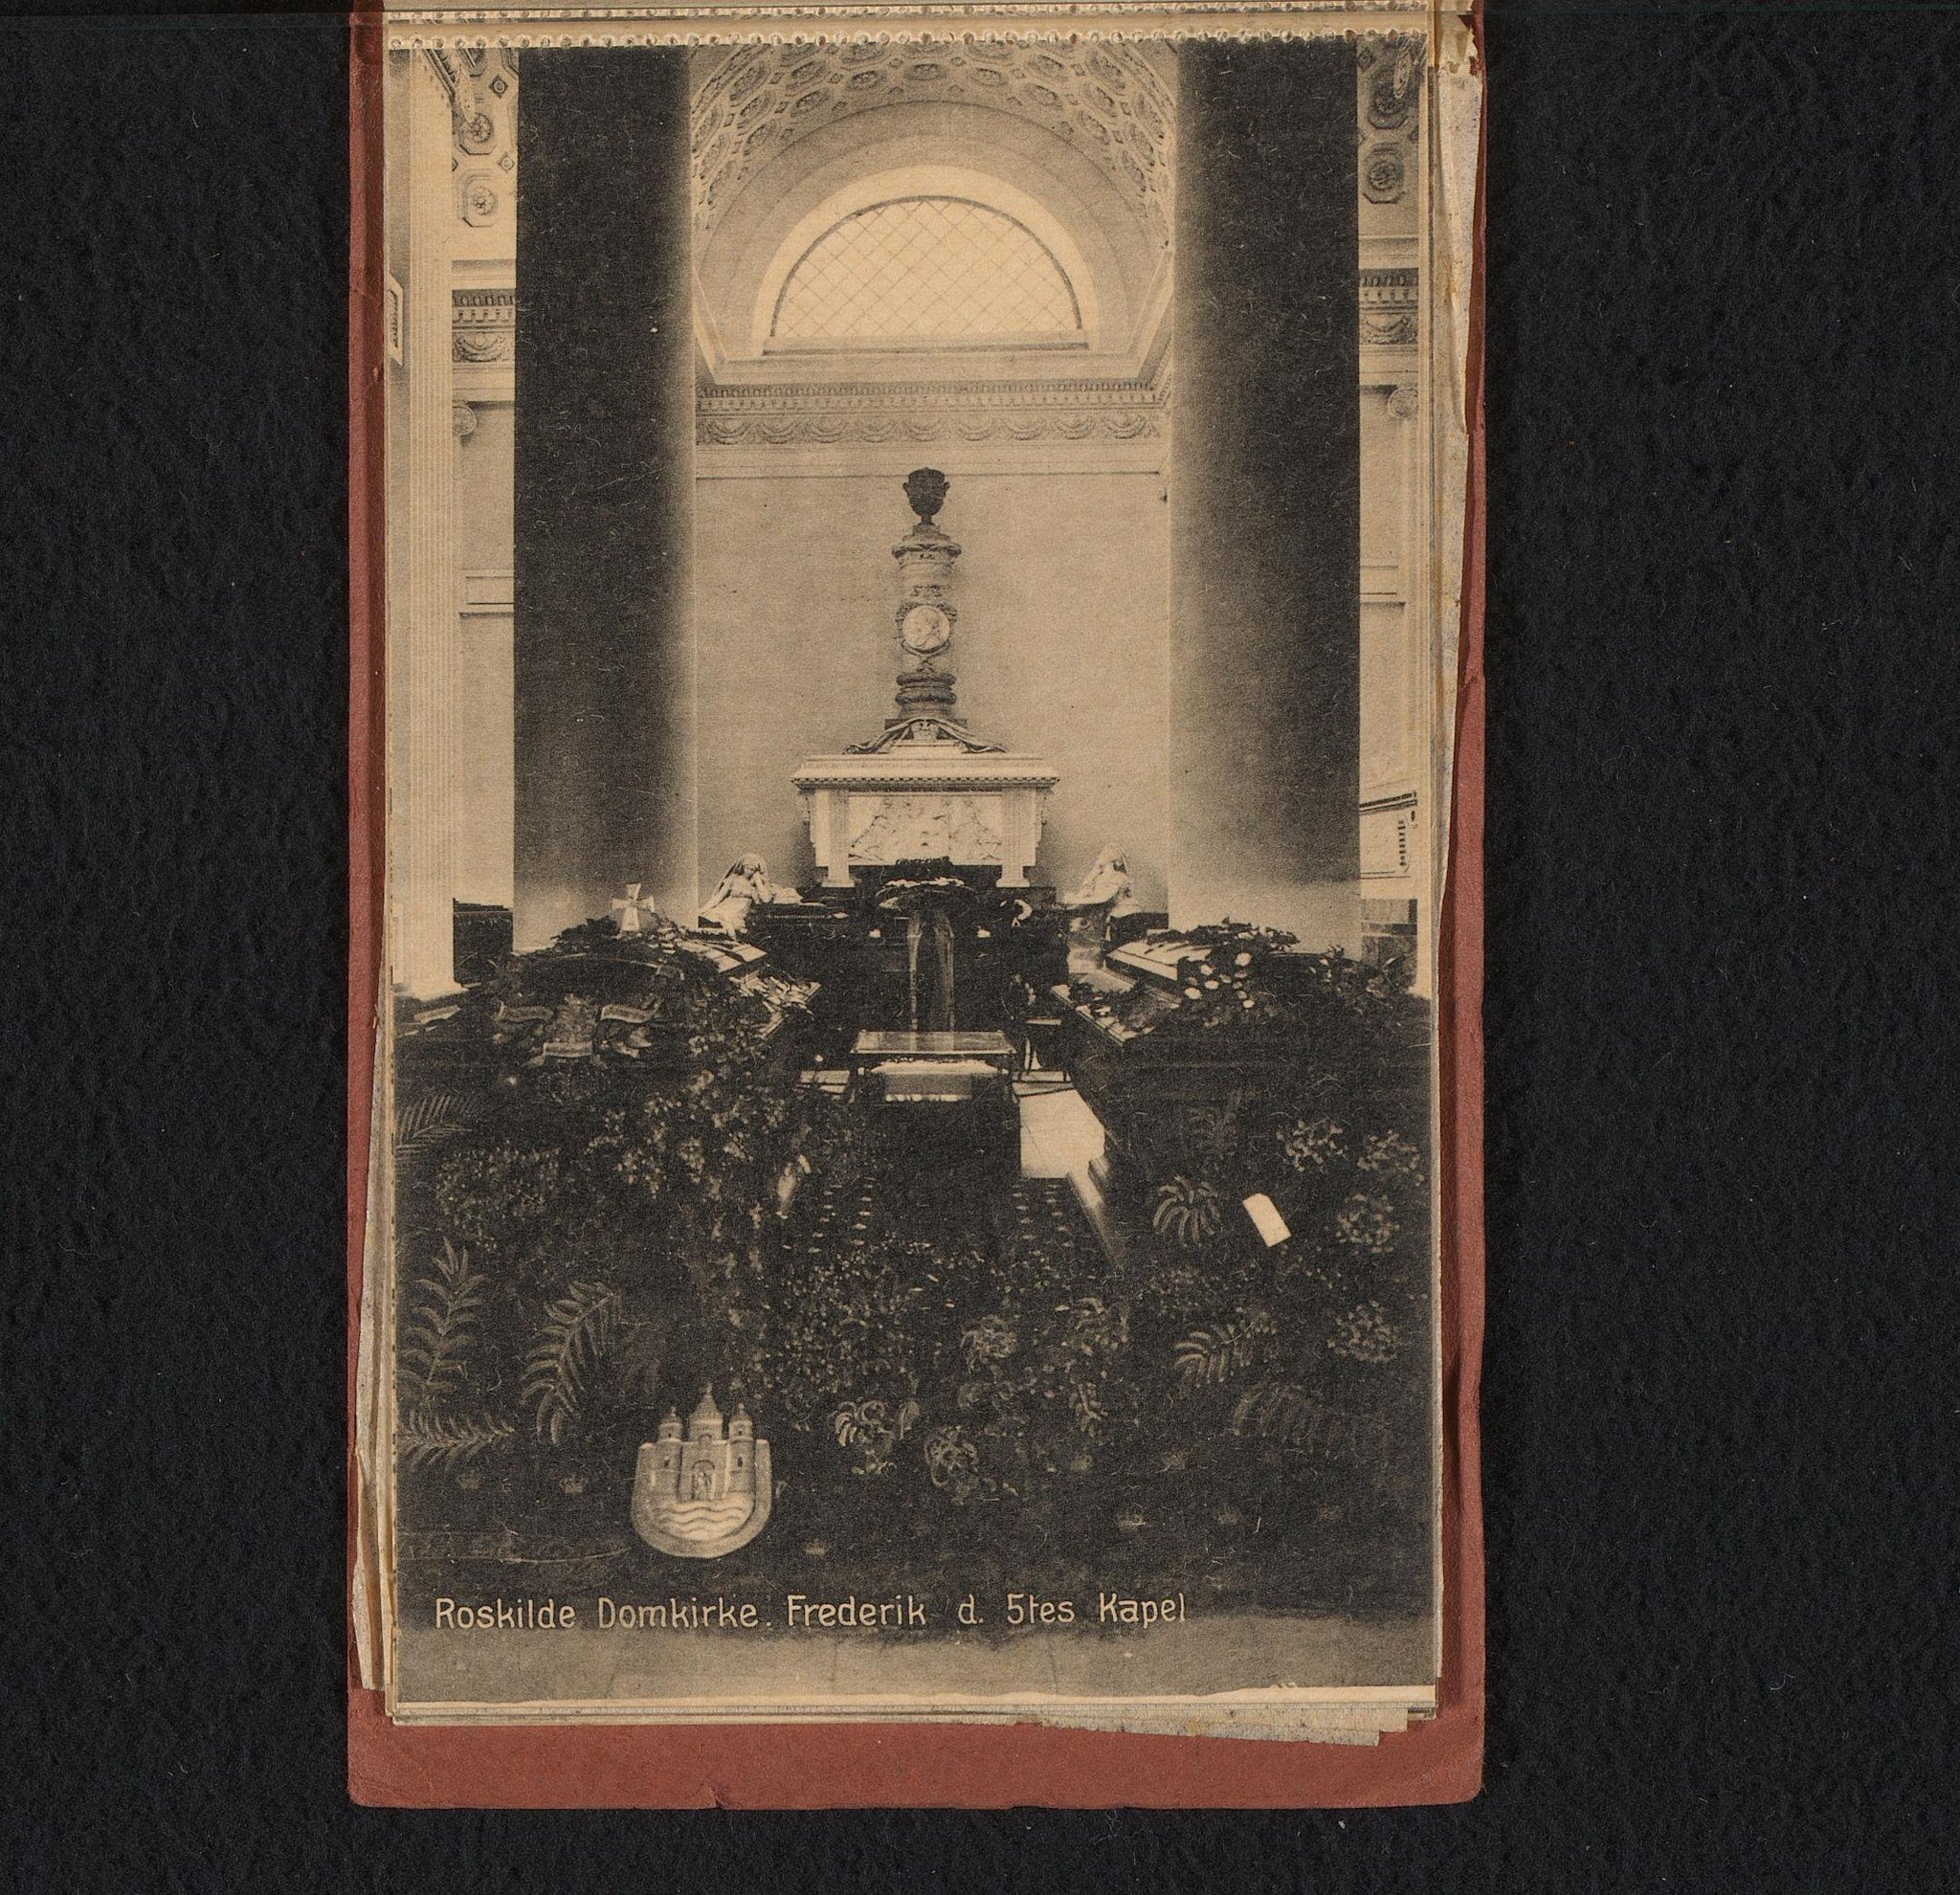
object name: photomechanical print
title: Frederik d. 5tes Kapel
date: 1906-1920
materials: cardboard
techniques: photograph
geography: roskilde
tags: the place of worship and its equipment ~ christian churches, grave, tomb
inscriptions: mark: ‘CS’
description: Prentbriefkaart maakt deel uit van een album.